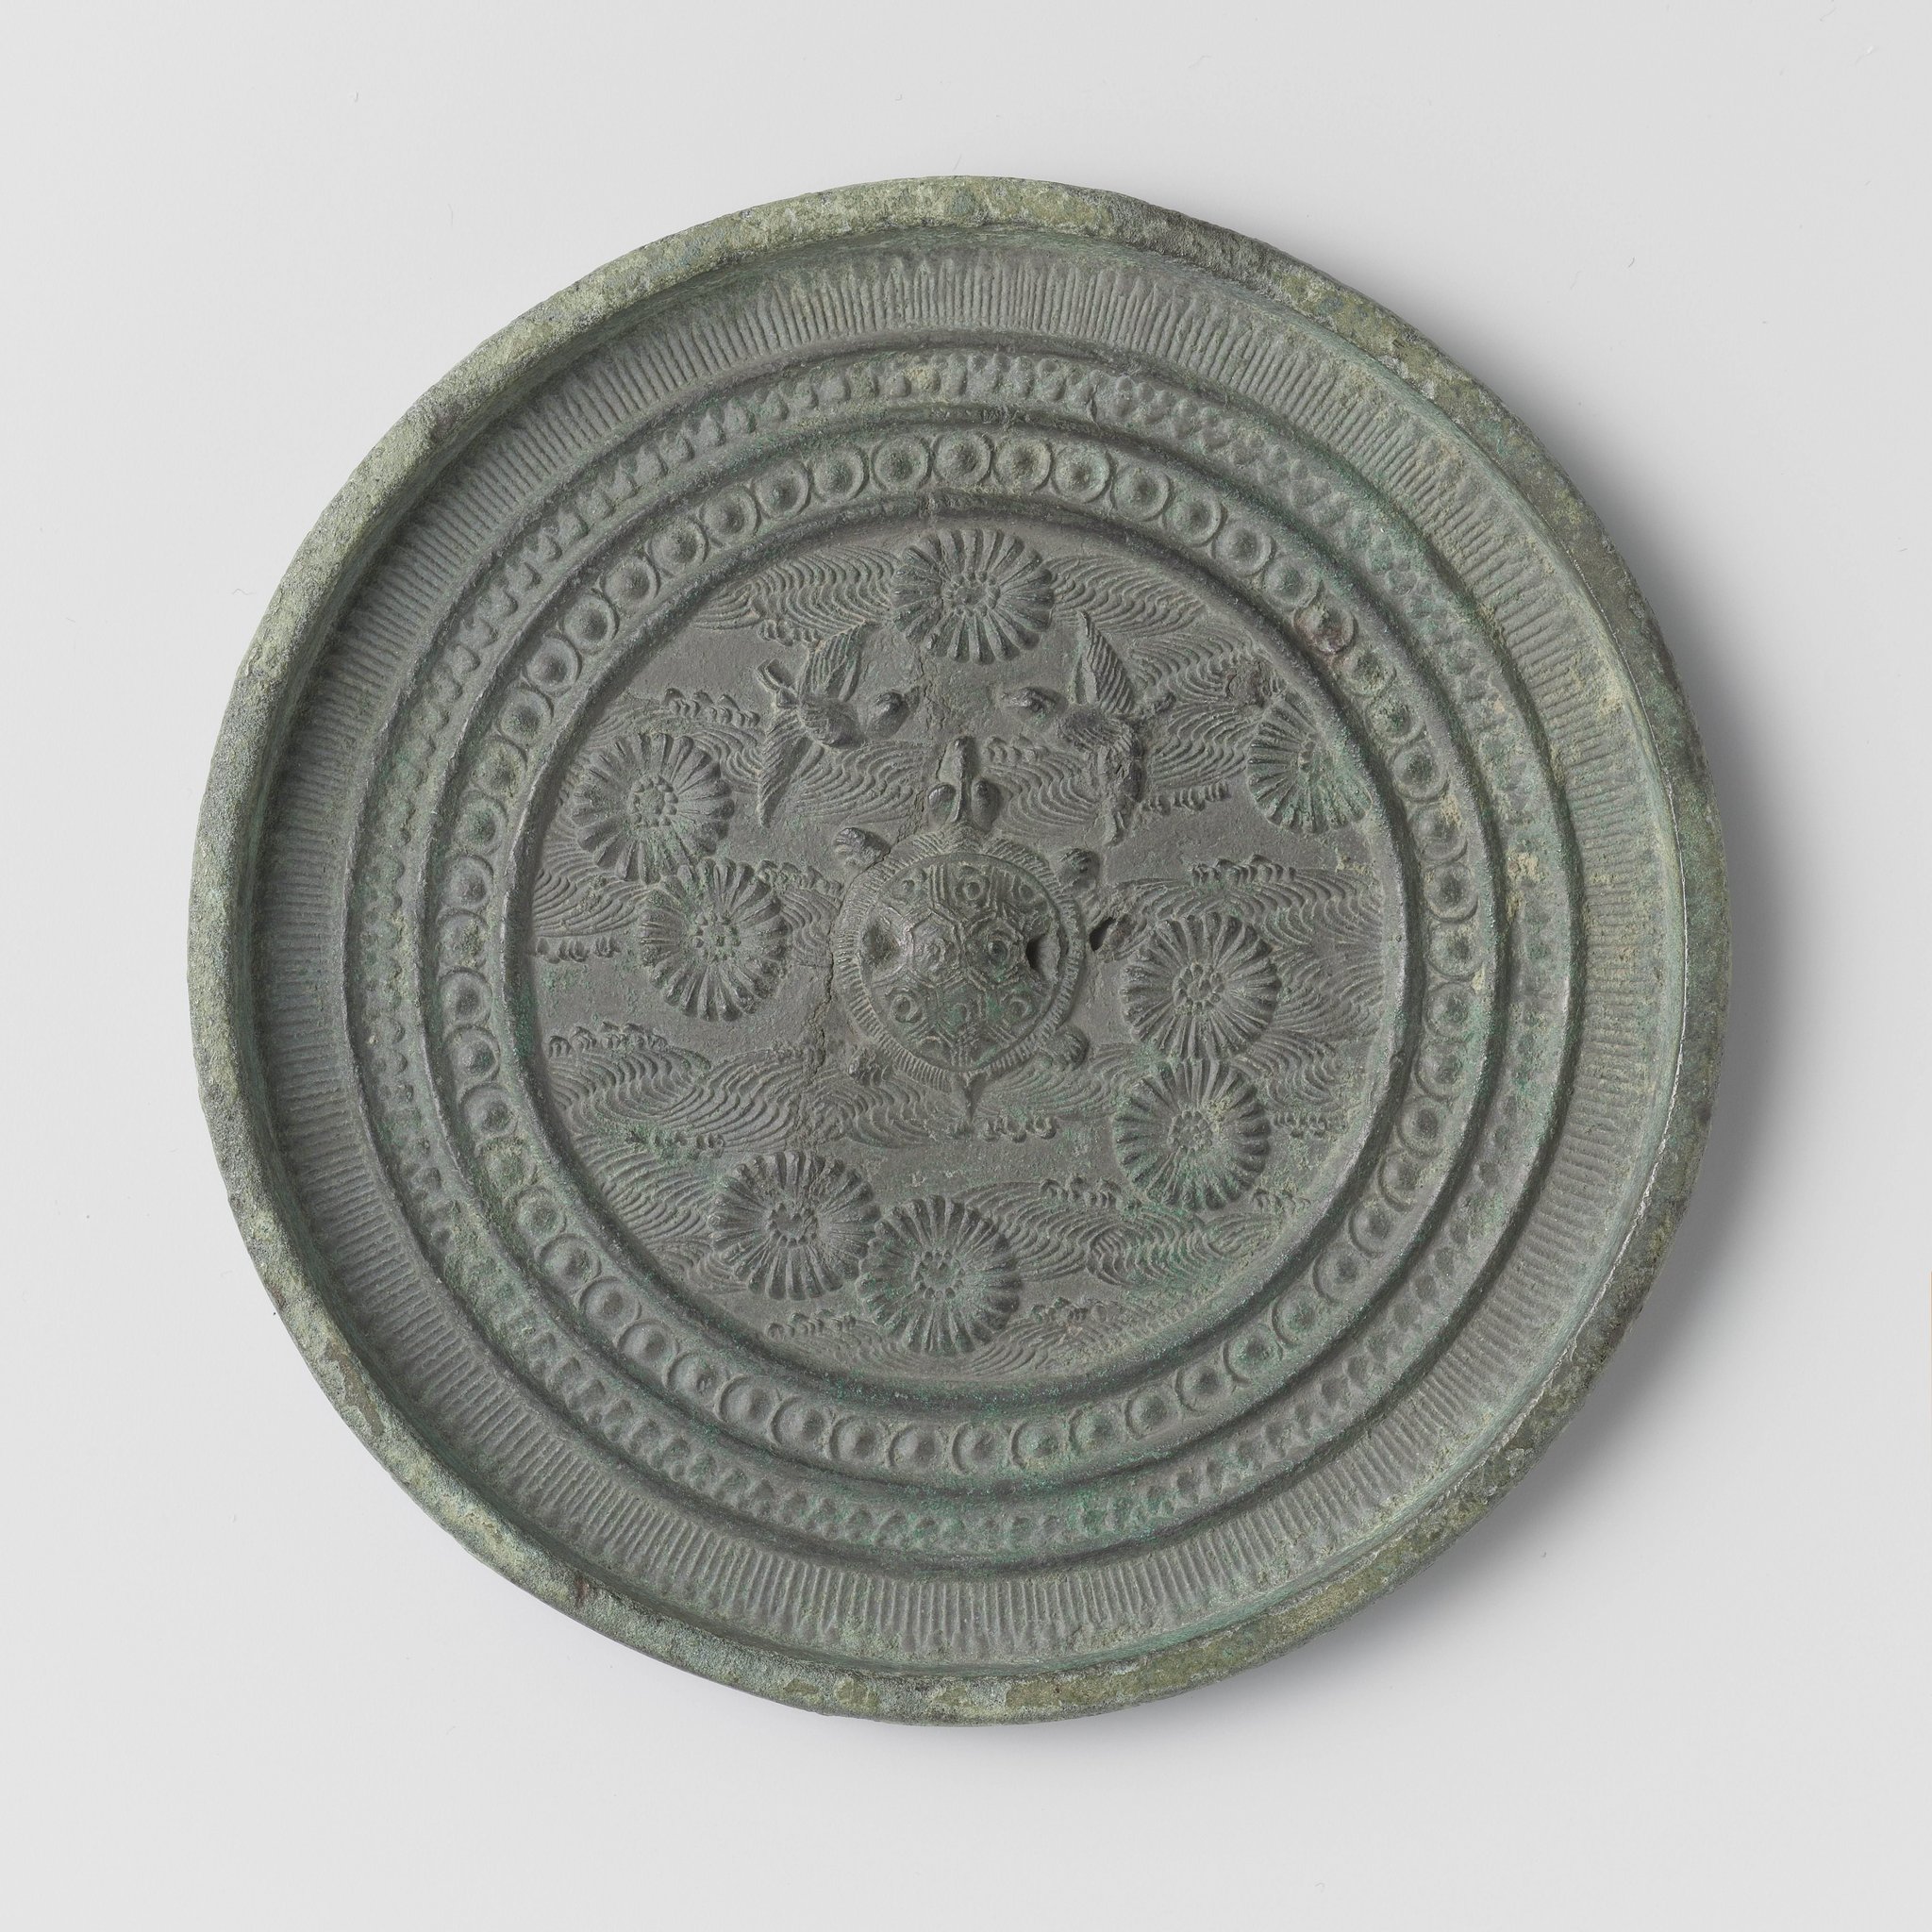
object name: mirror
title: Spiegel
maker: Anonymous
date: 1100-1185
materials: bronze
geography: japan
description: Spiegel met een knop in de vorm van een schildpad. Het middenveld is versierd met vogels en chrysanten.